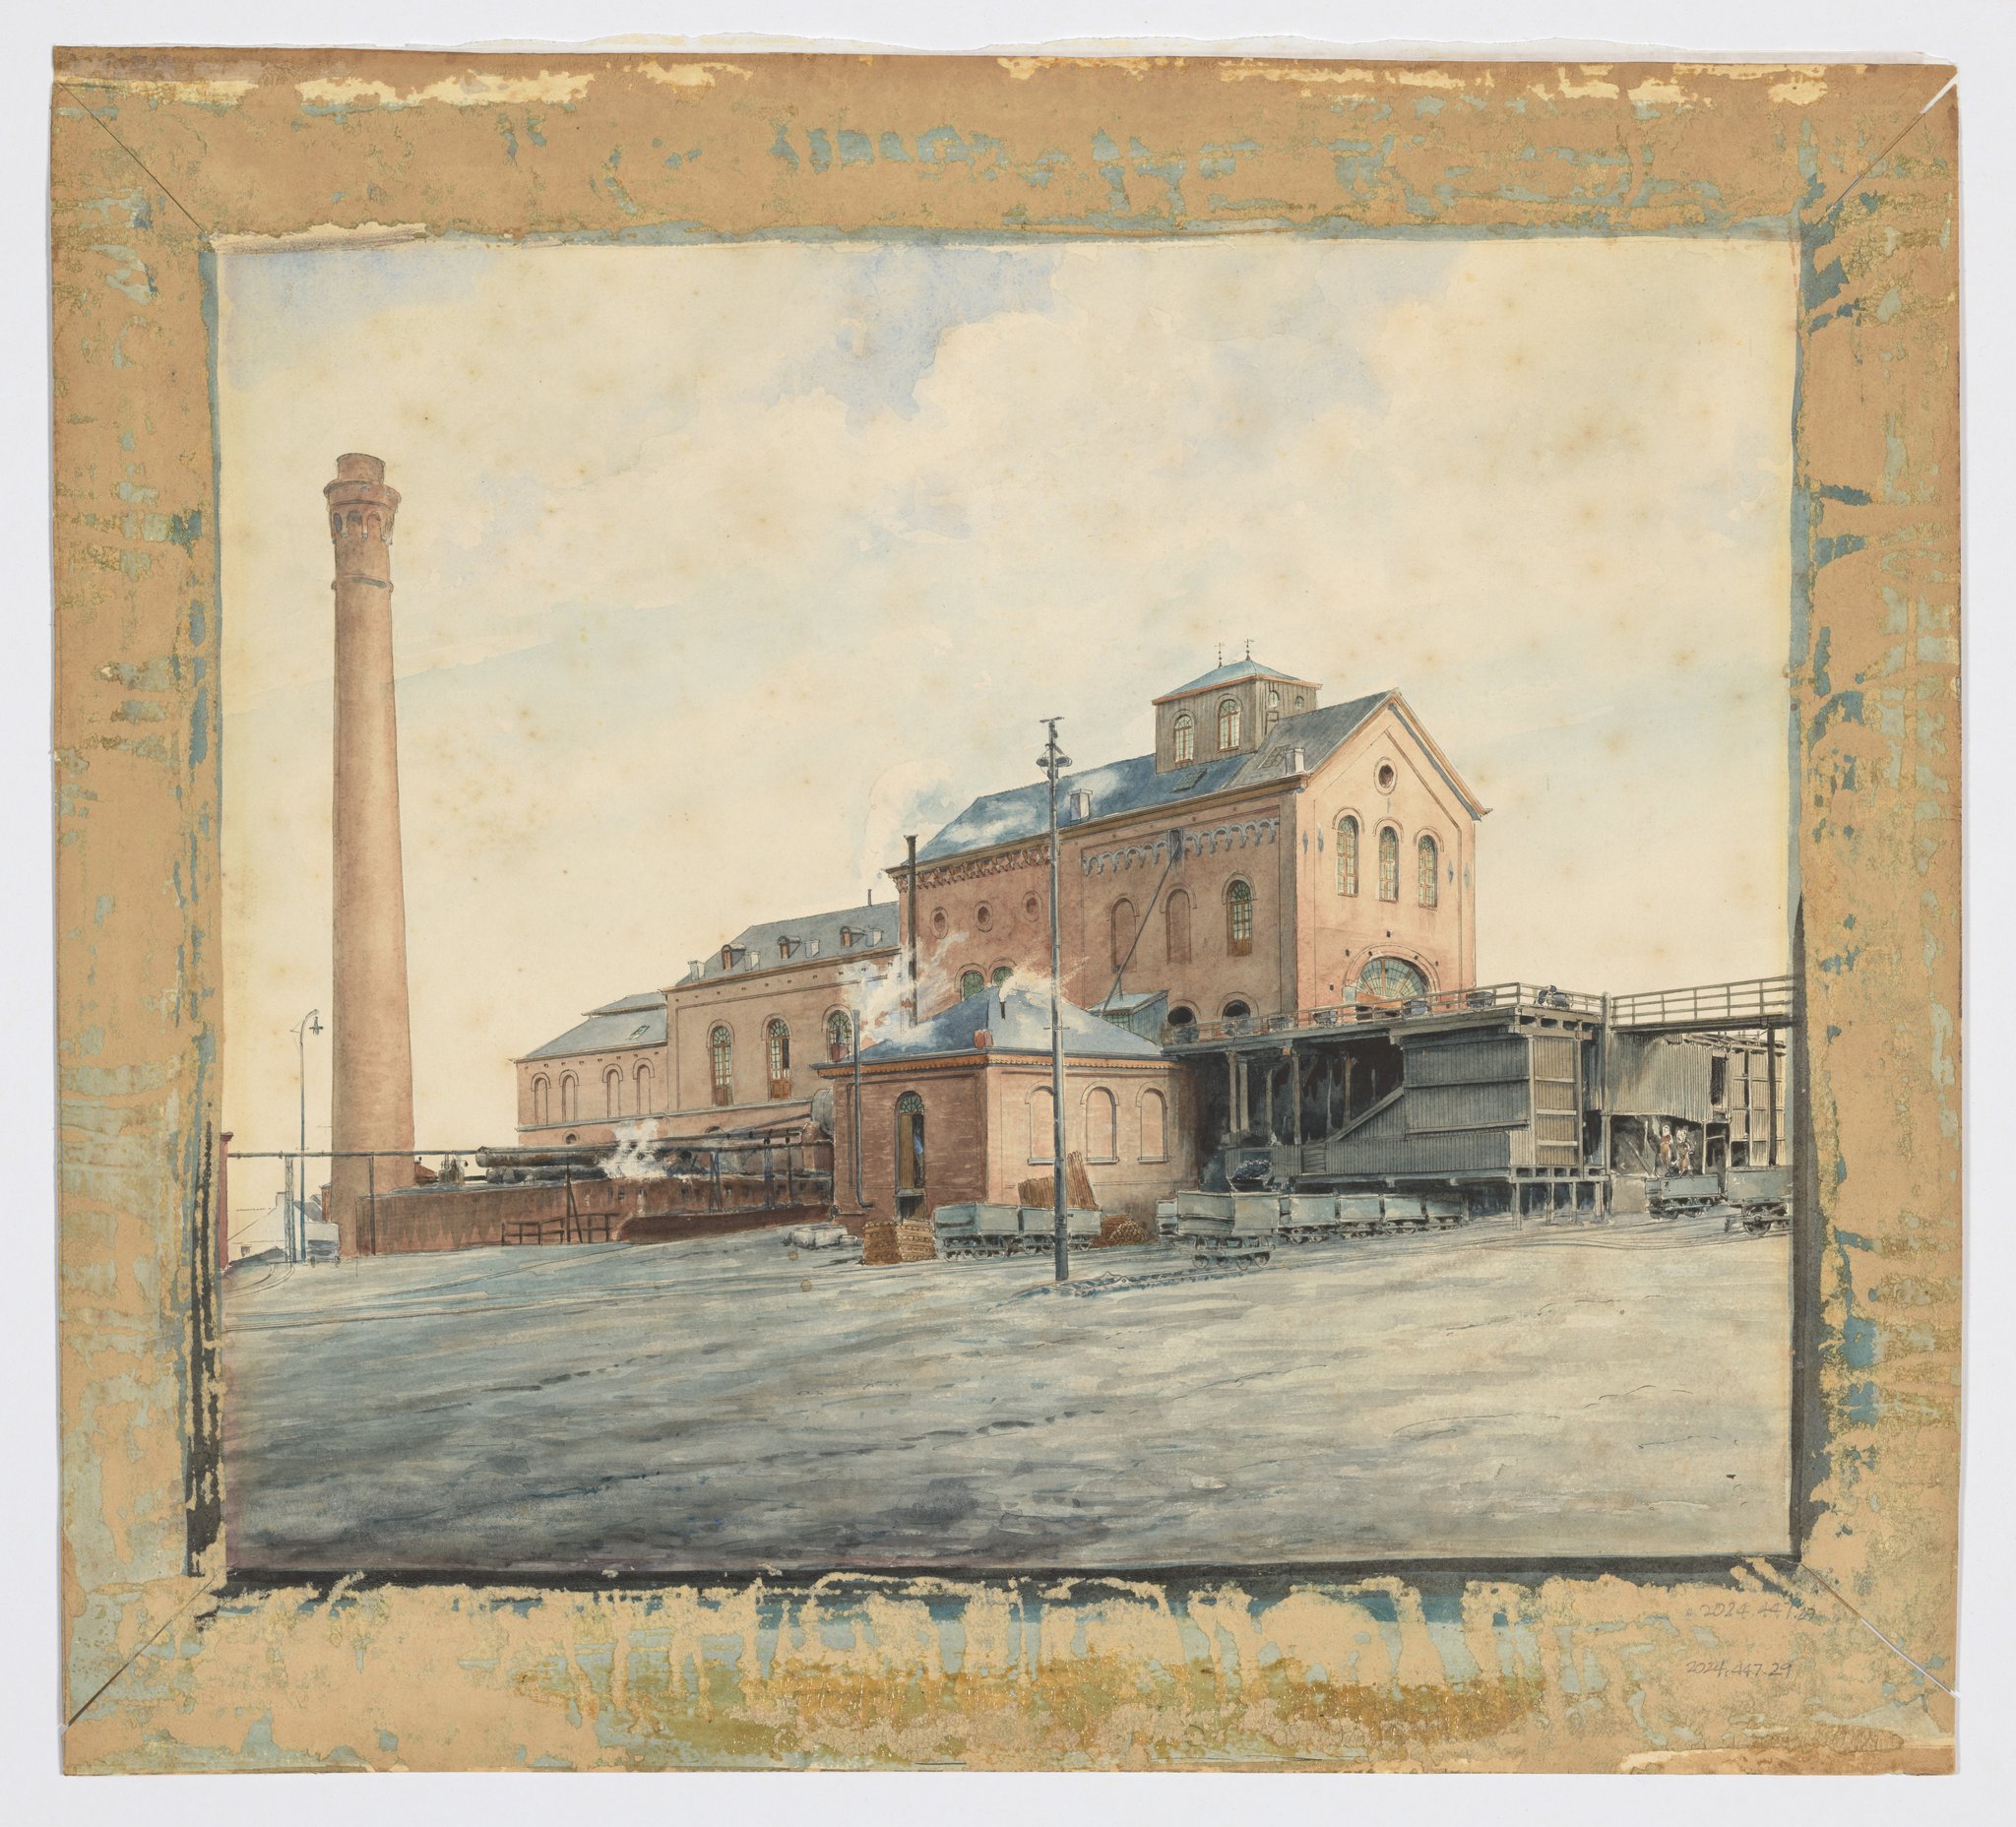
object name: drawing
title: Perspective View from a series of Mines and Factories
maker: th (thomas?) defoiss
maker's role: artist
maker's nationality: french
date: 1905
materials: graphite, ink, watercolor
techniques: pen